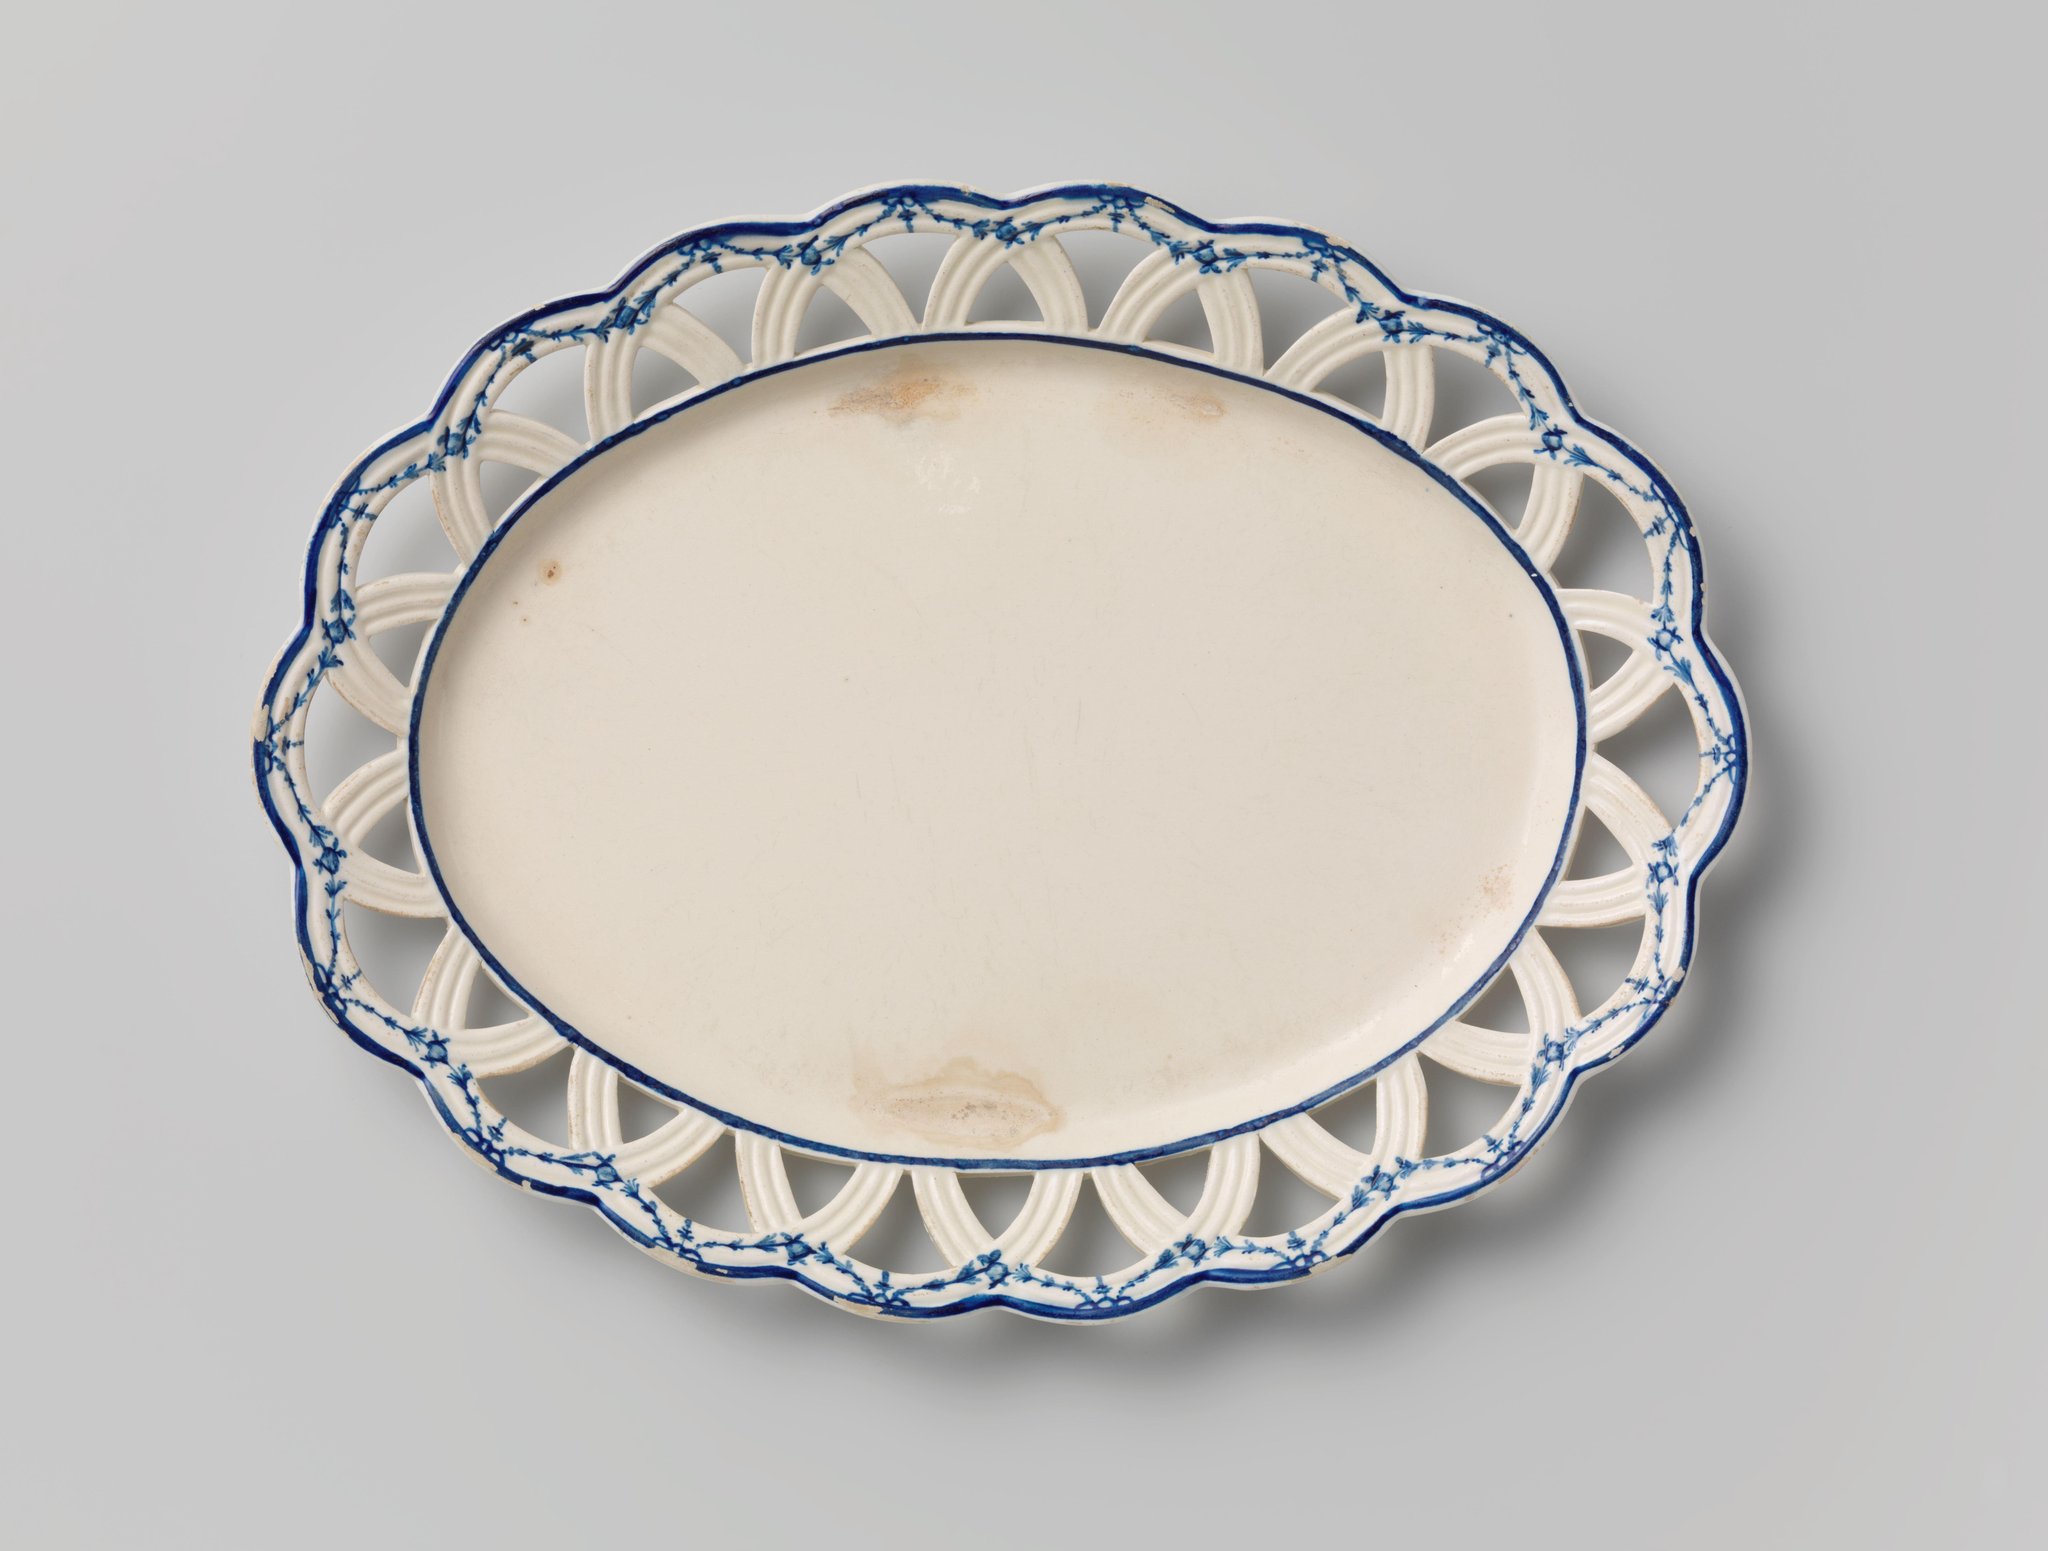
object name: platter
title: Onderschotel van Engels hardgebakken aardewerk, Boch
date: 1775-1810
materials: earthenware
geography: luxembourg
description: Schotel van hardgebakken aardewerk. De schotel heeft een geschulpte rand en is beschilderd in blauw, met langs de rand een bloemguirlande. De schotel wordt als onderschotel bewaard bij een mand (BK-1978-108-A), ze horen echter niet bij elkaar.